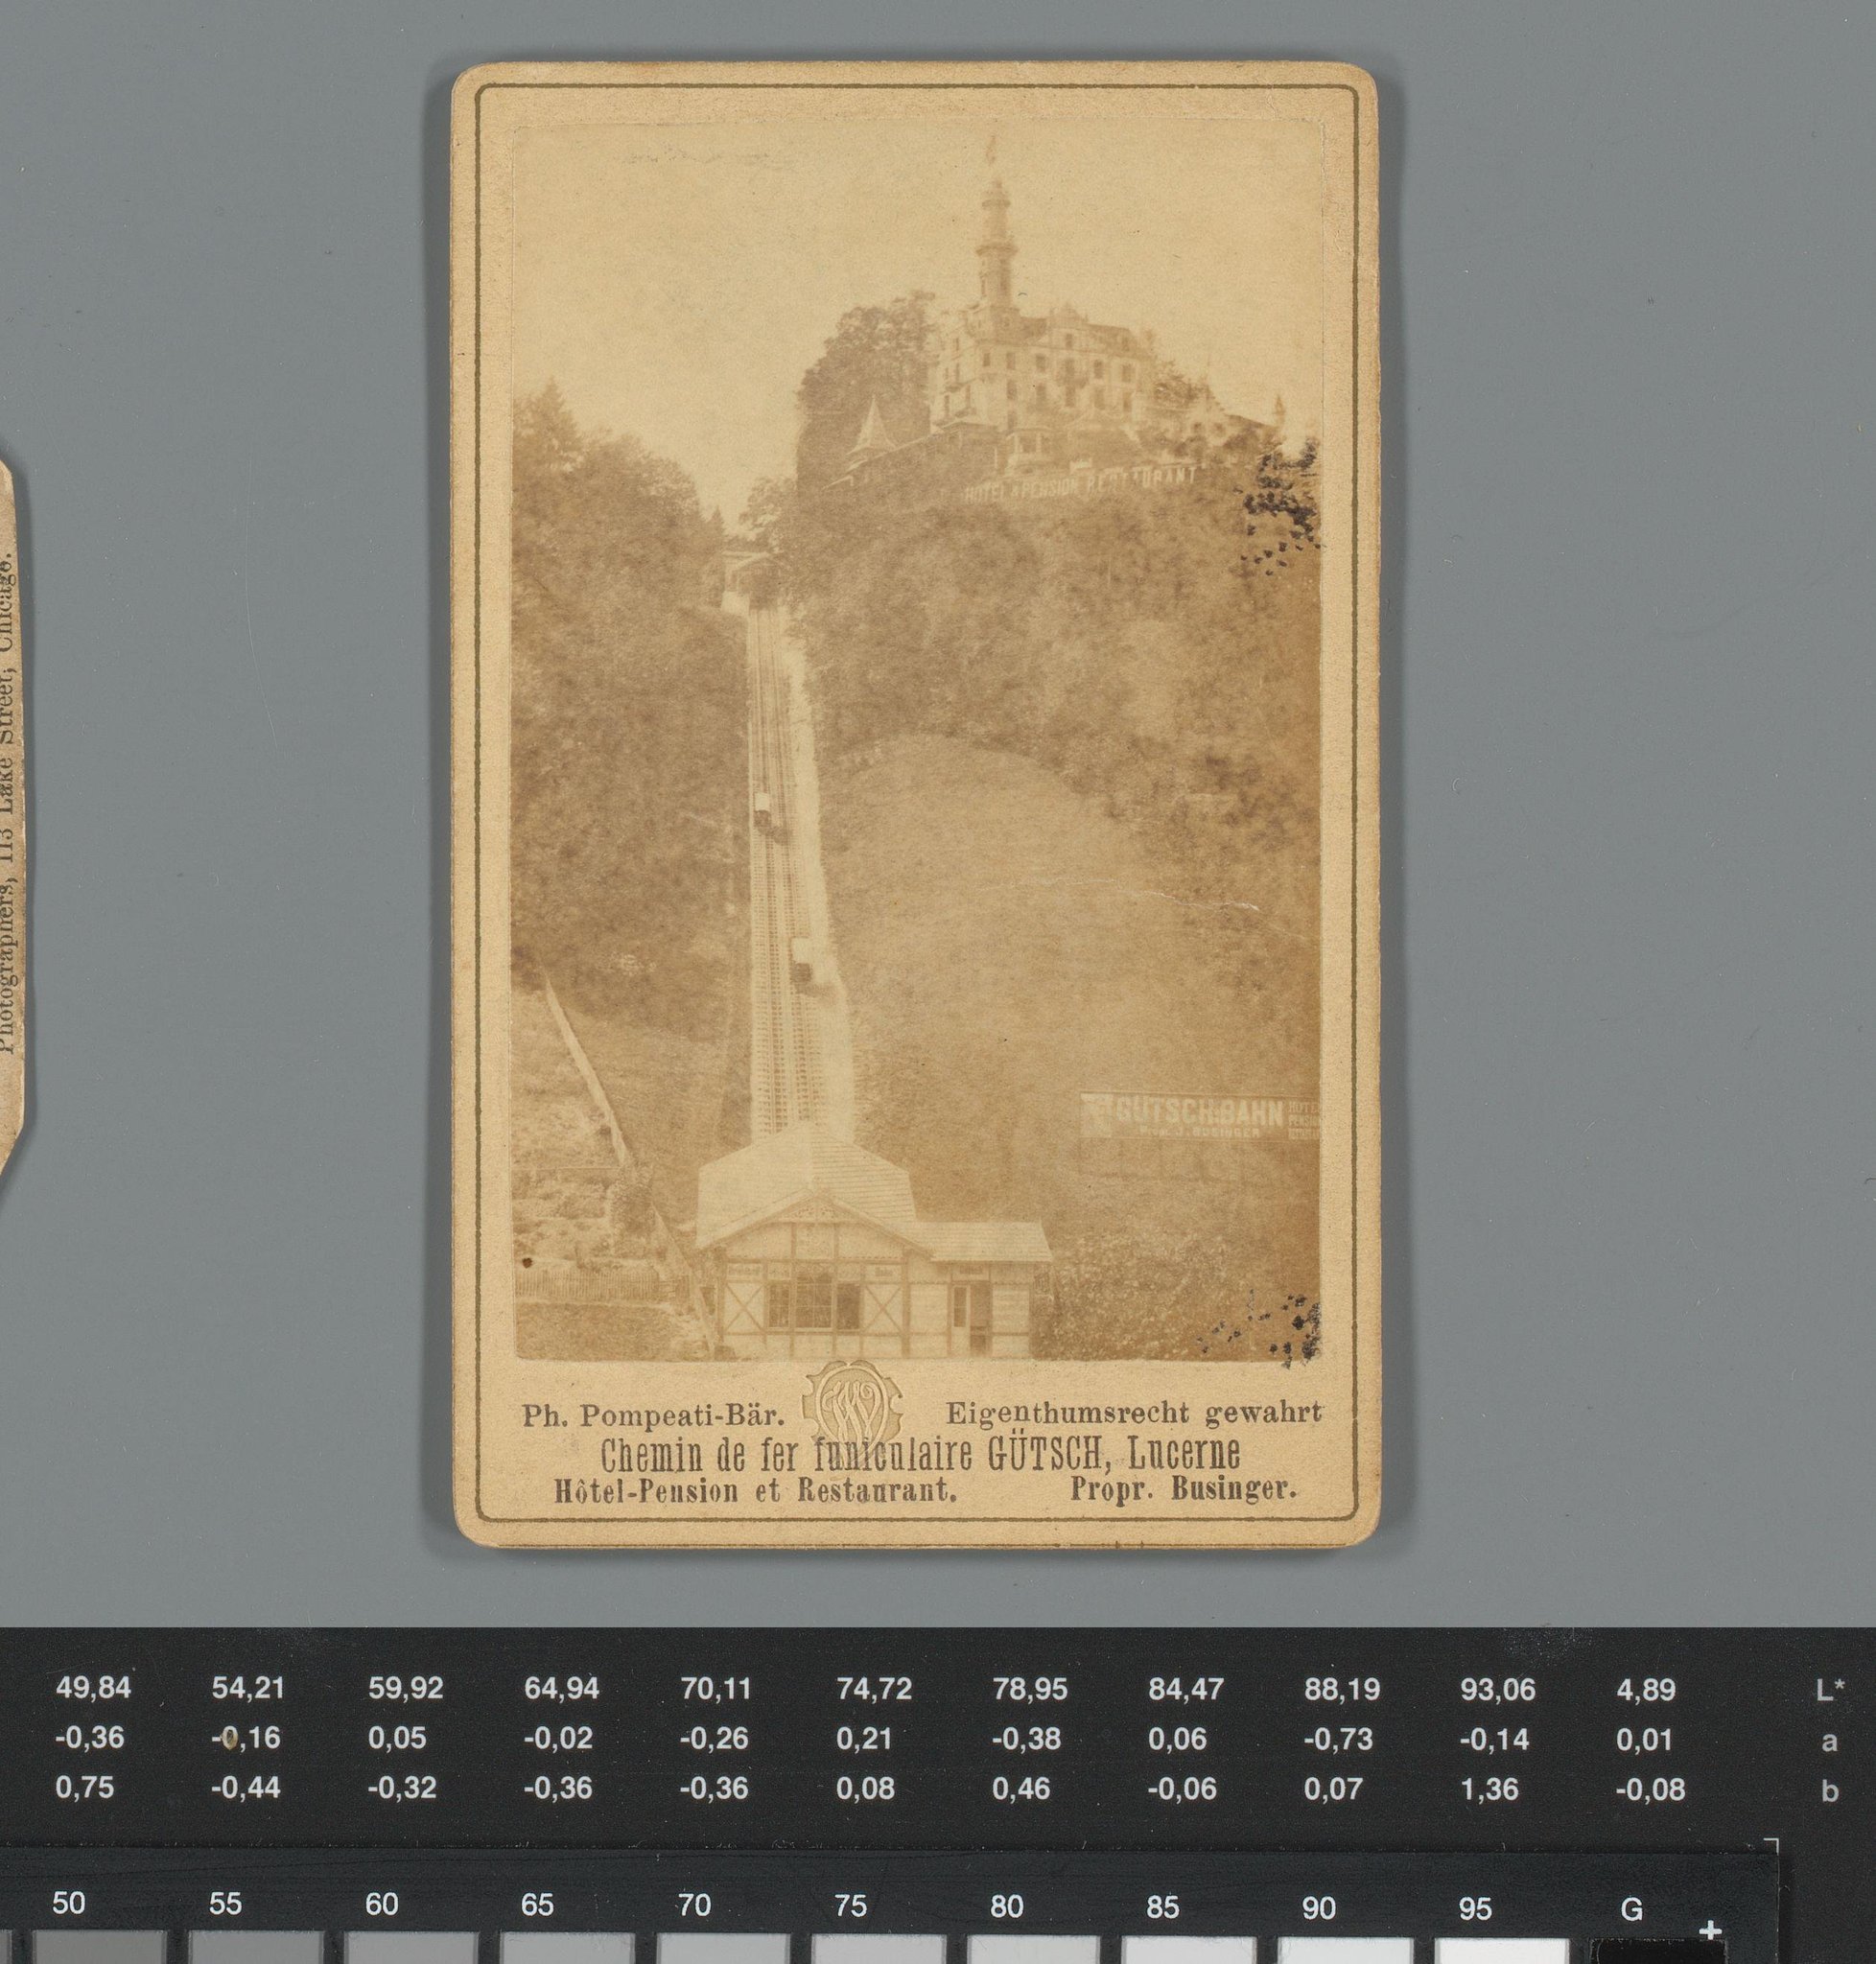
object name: photograph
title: Reclame voor restaurant en hotel Chateau Gütsoh in Luzern, Zwitserland, met gezicht op de kabelbaan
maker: heinrich pompeati bär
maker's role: fotograaf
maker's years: 1859-1921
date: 1850-1915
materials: cardboard, photographic support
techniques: albumen print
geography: lucerne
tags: advertising, funicular railway, restaurant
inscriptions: inscription: ‘Ph. Pompeati-Bär. Eigenthumsrecht gewahrt/(...)’